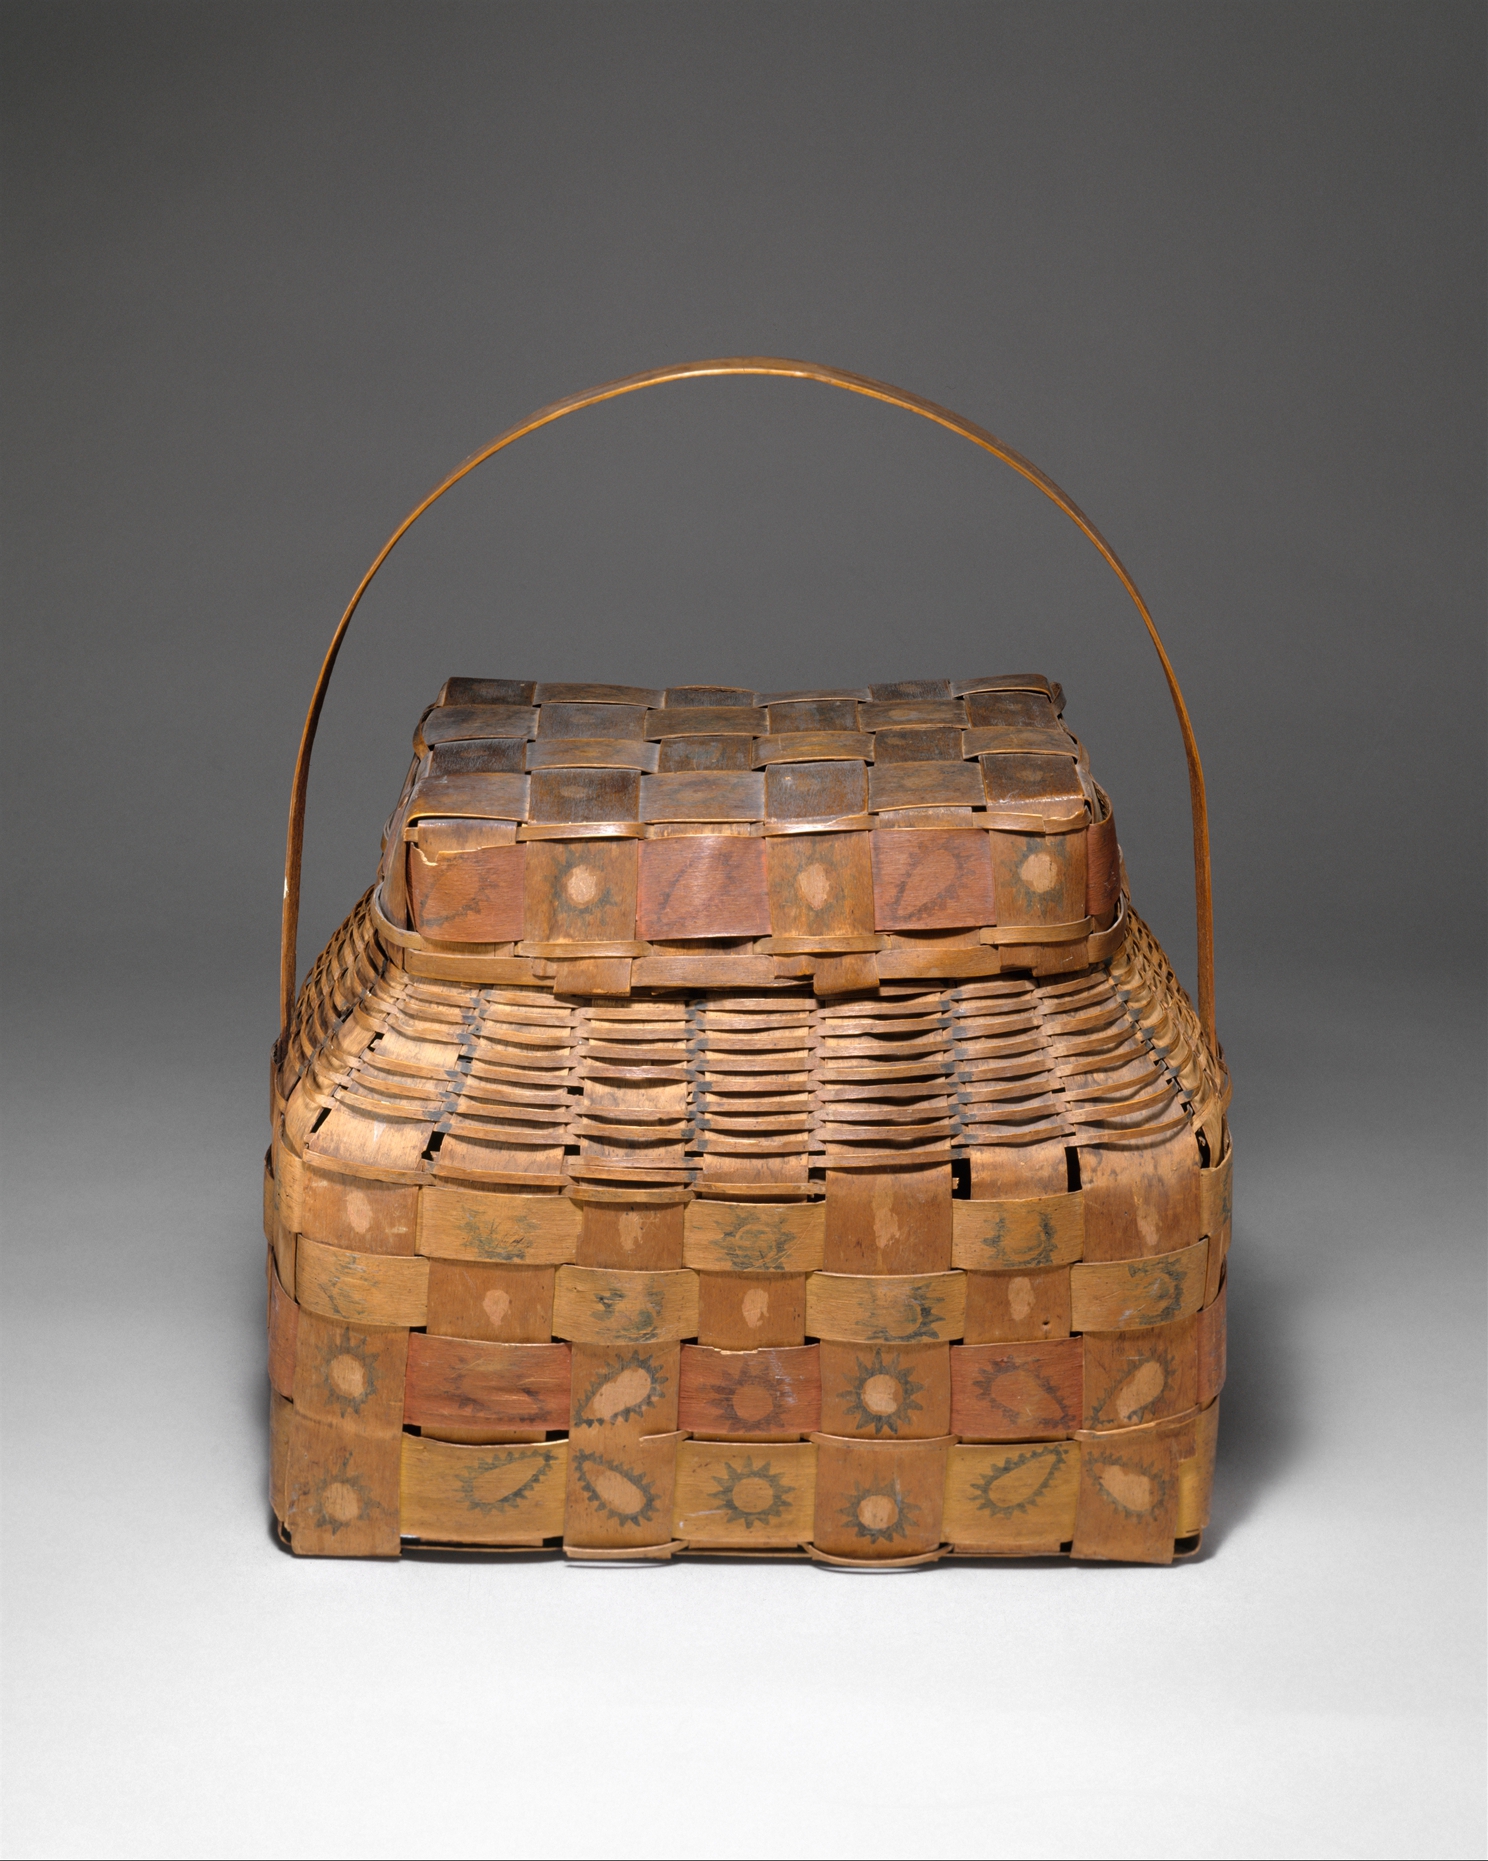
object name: basket with lid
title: Lidded Basket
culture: onondaga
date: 1840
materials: wood, pigment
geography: united states